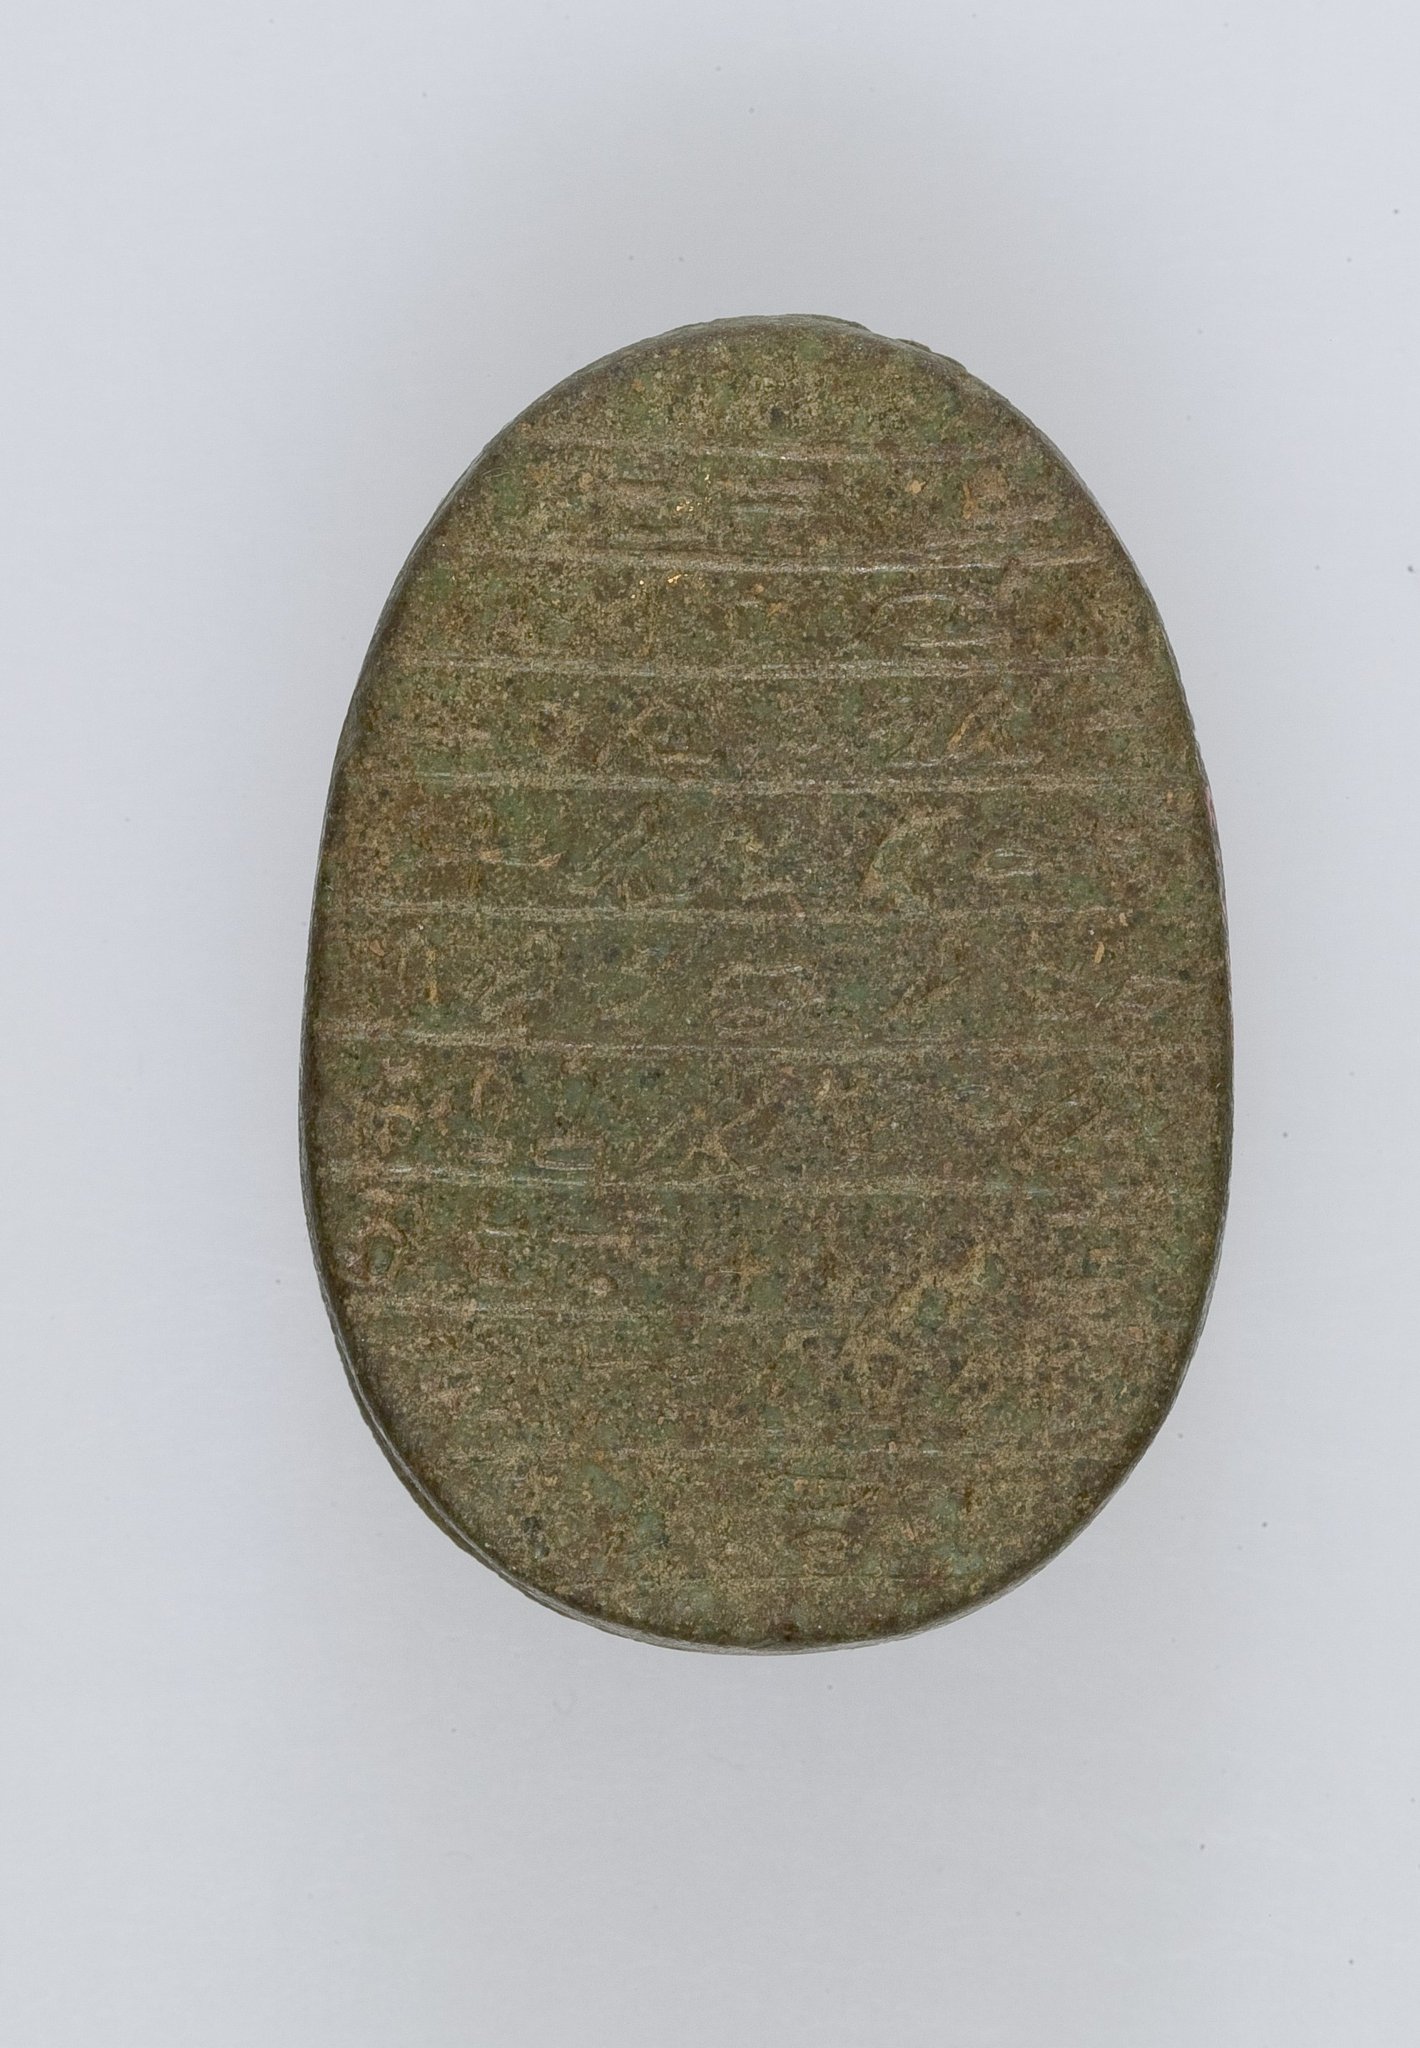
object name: heart scarab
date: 1550-1295 BCE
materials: stone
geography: egypt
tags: hieroglyphs,scarabs